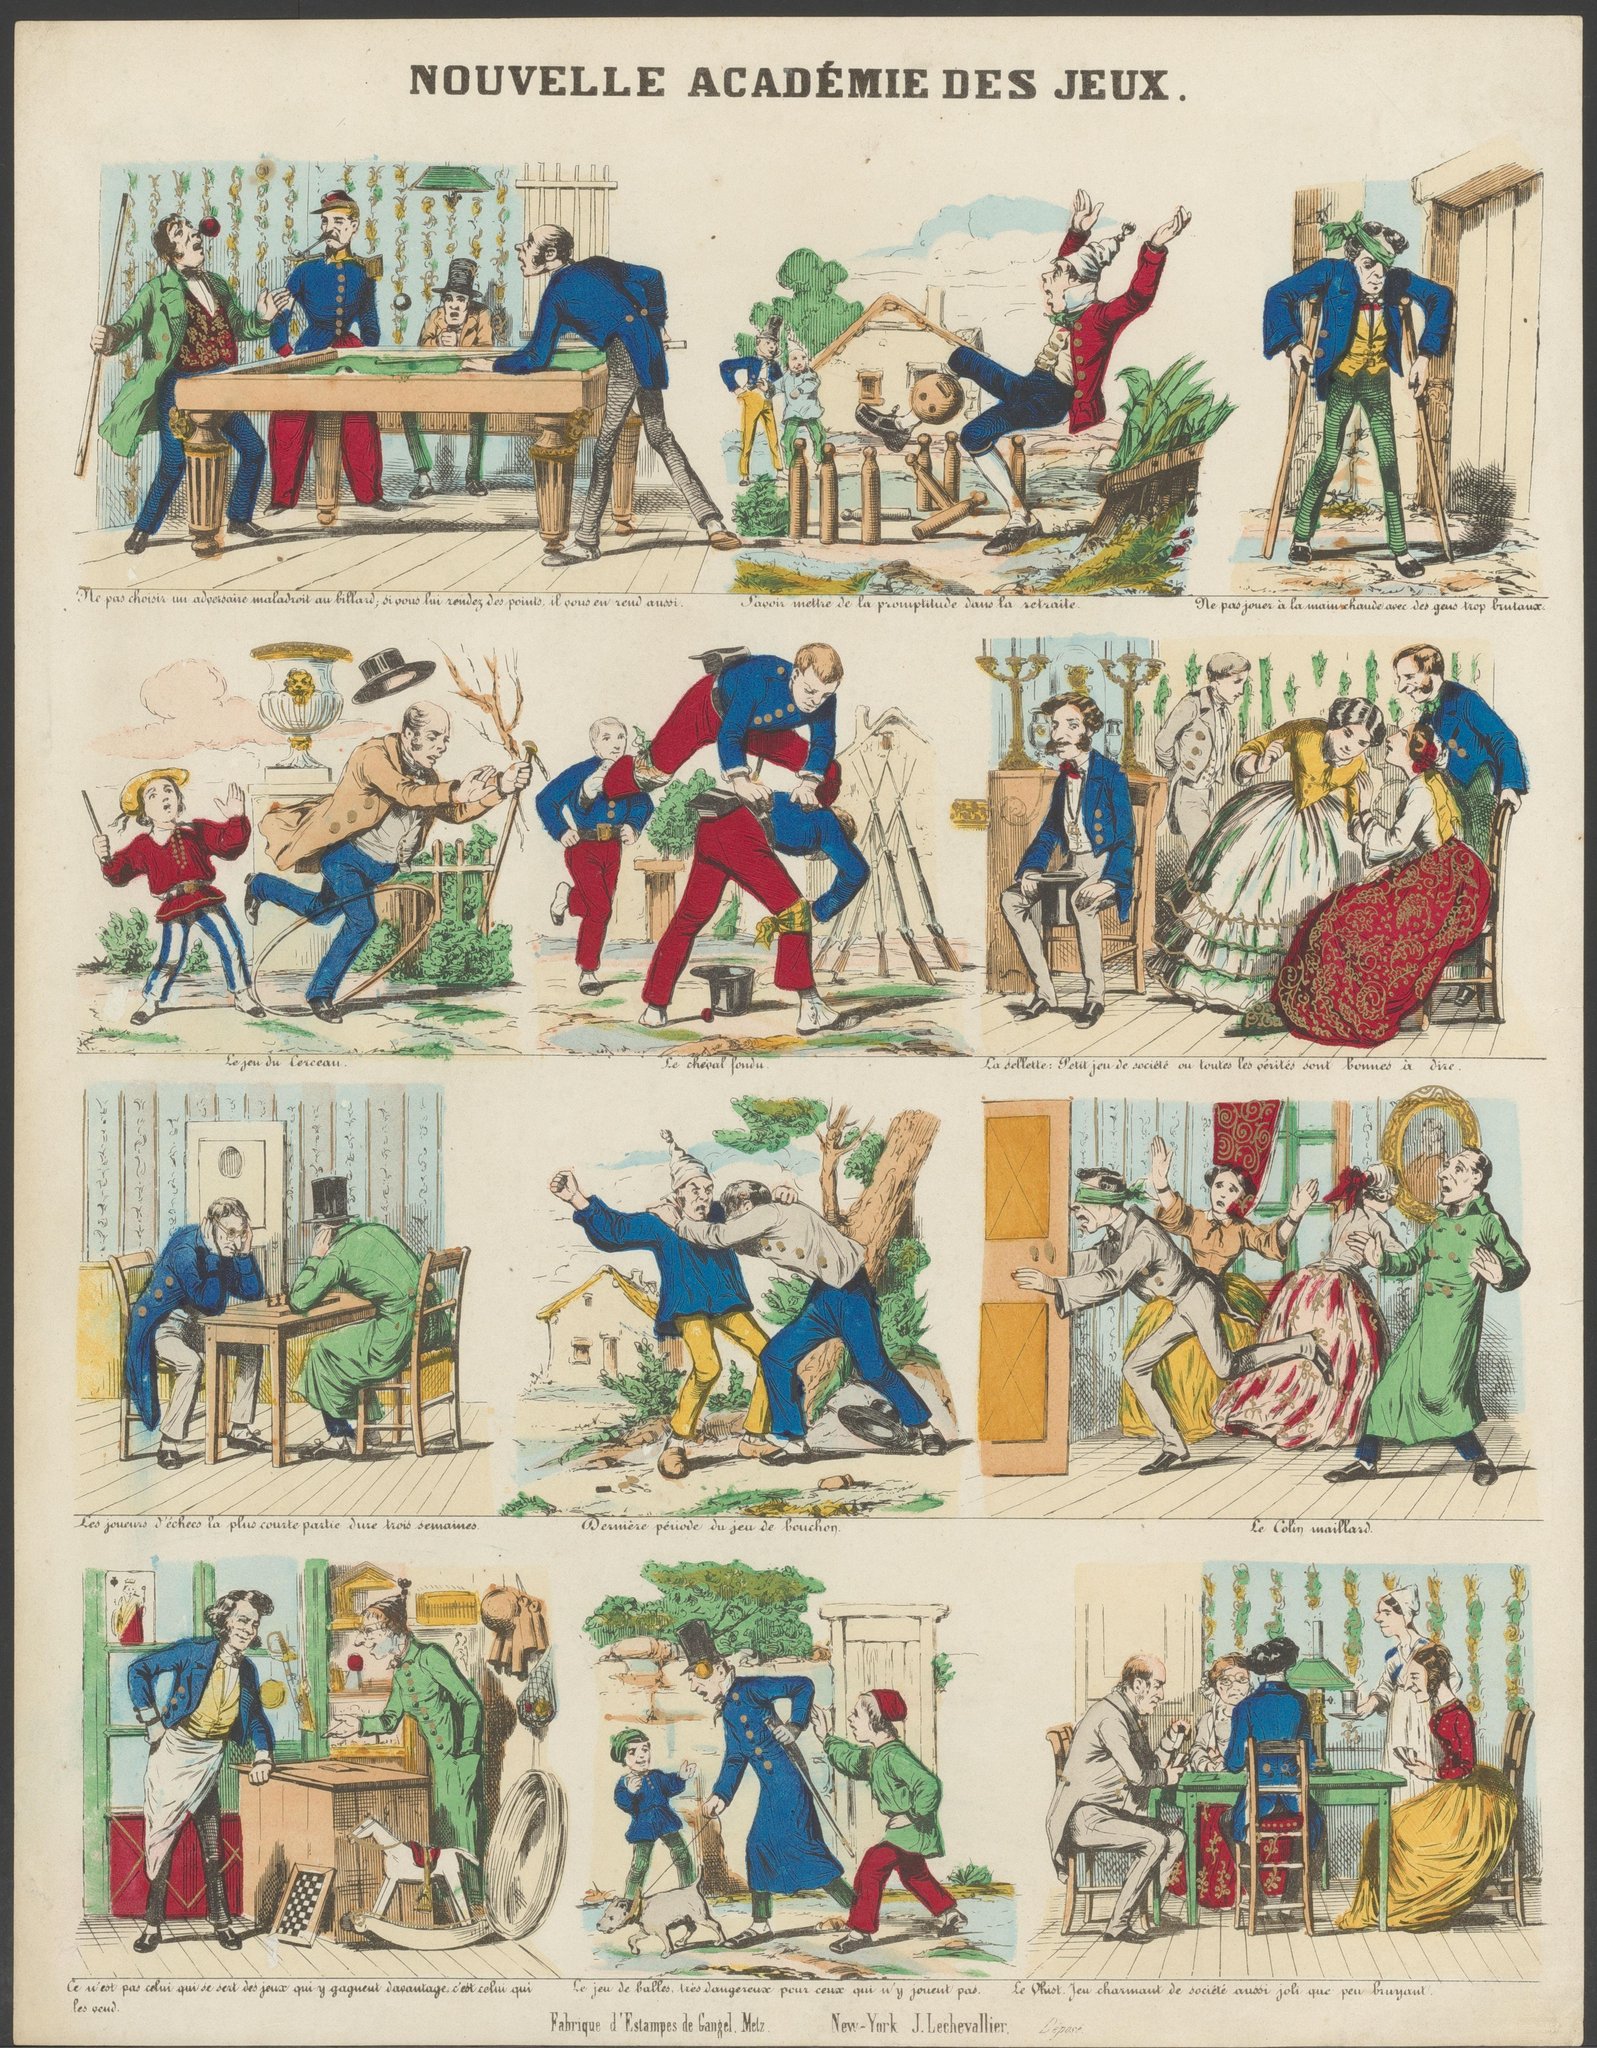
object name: print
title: Uit de hand gelopen spellen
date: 1840-1868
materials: paint, paper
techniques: hand coloring, lithograph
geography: metz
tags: group games, party games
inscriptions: collector's mark: Lugt 1641, collector's mark: Lugt 2233, : ‘Déposé’, stamp:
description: Twaalf voorstelling met spellen die uit de hand lopen. Onder iedere voorstelling een regel tekst. Onderwerpsrubrieken binnen de Atlas Zeden en Gewoonten: Zeden en Gewoonten in Engeren Zin, Des menschen beging, midden en einde, Kinderleven – Kinderspel en Kinderprenten.